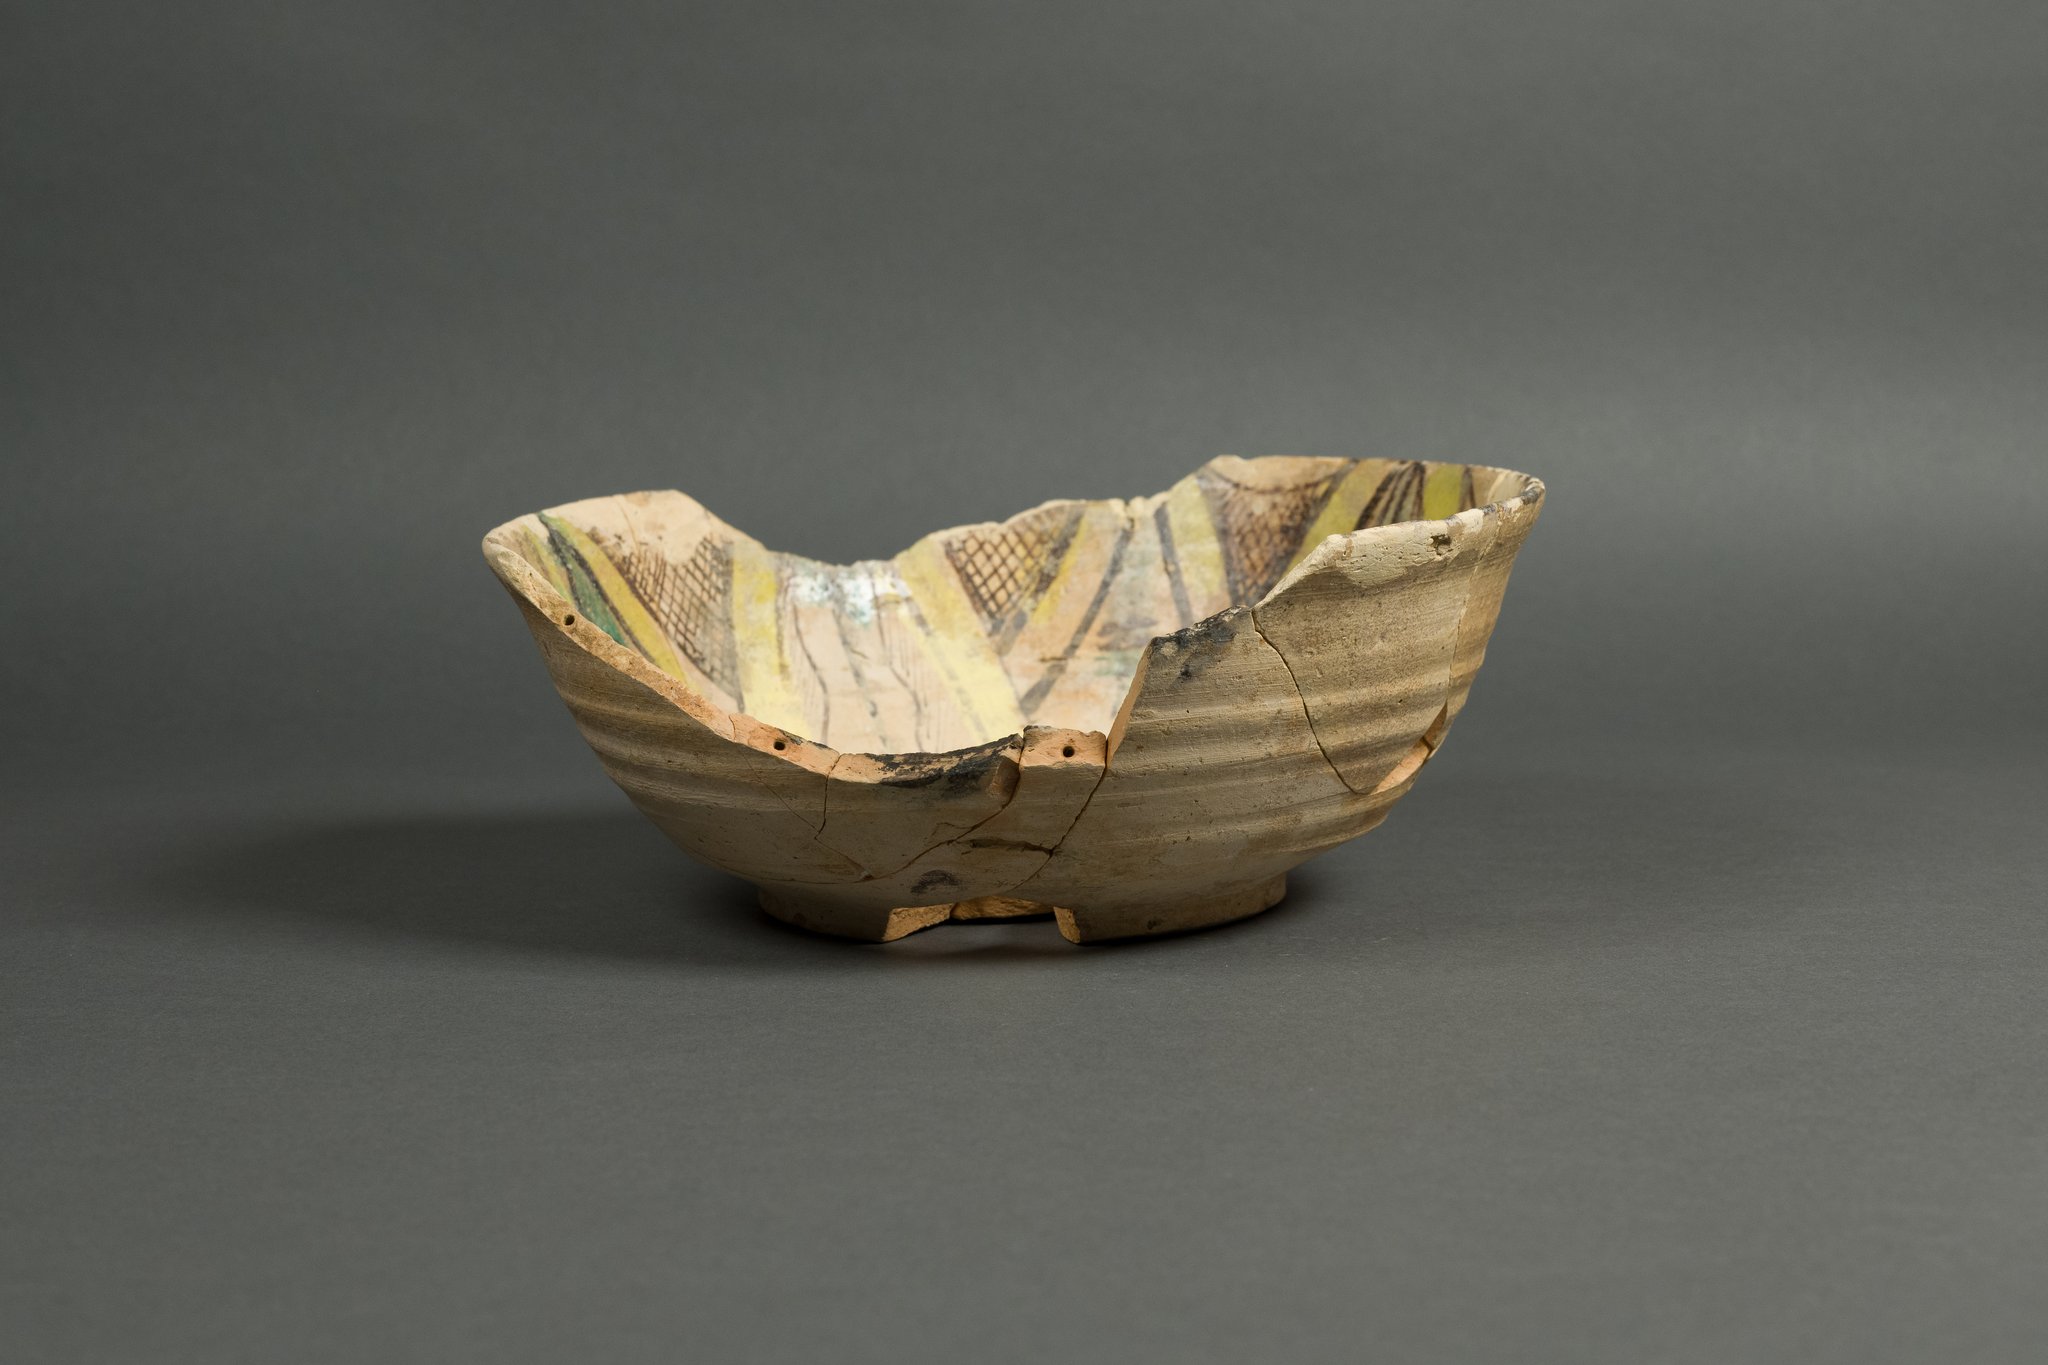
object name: bowl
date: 767-900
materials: earthenware, glaze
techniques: polychrome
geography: iran